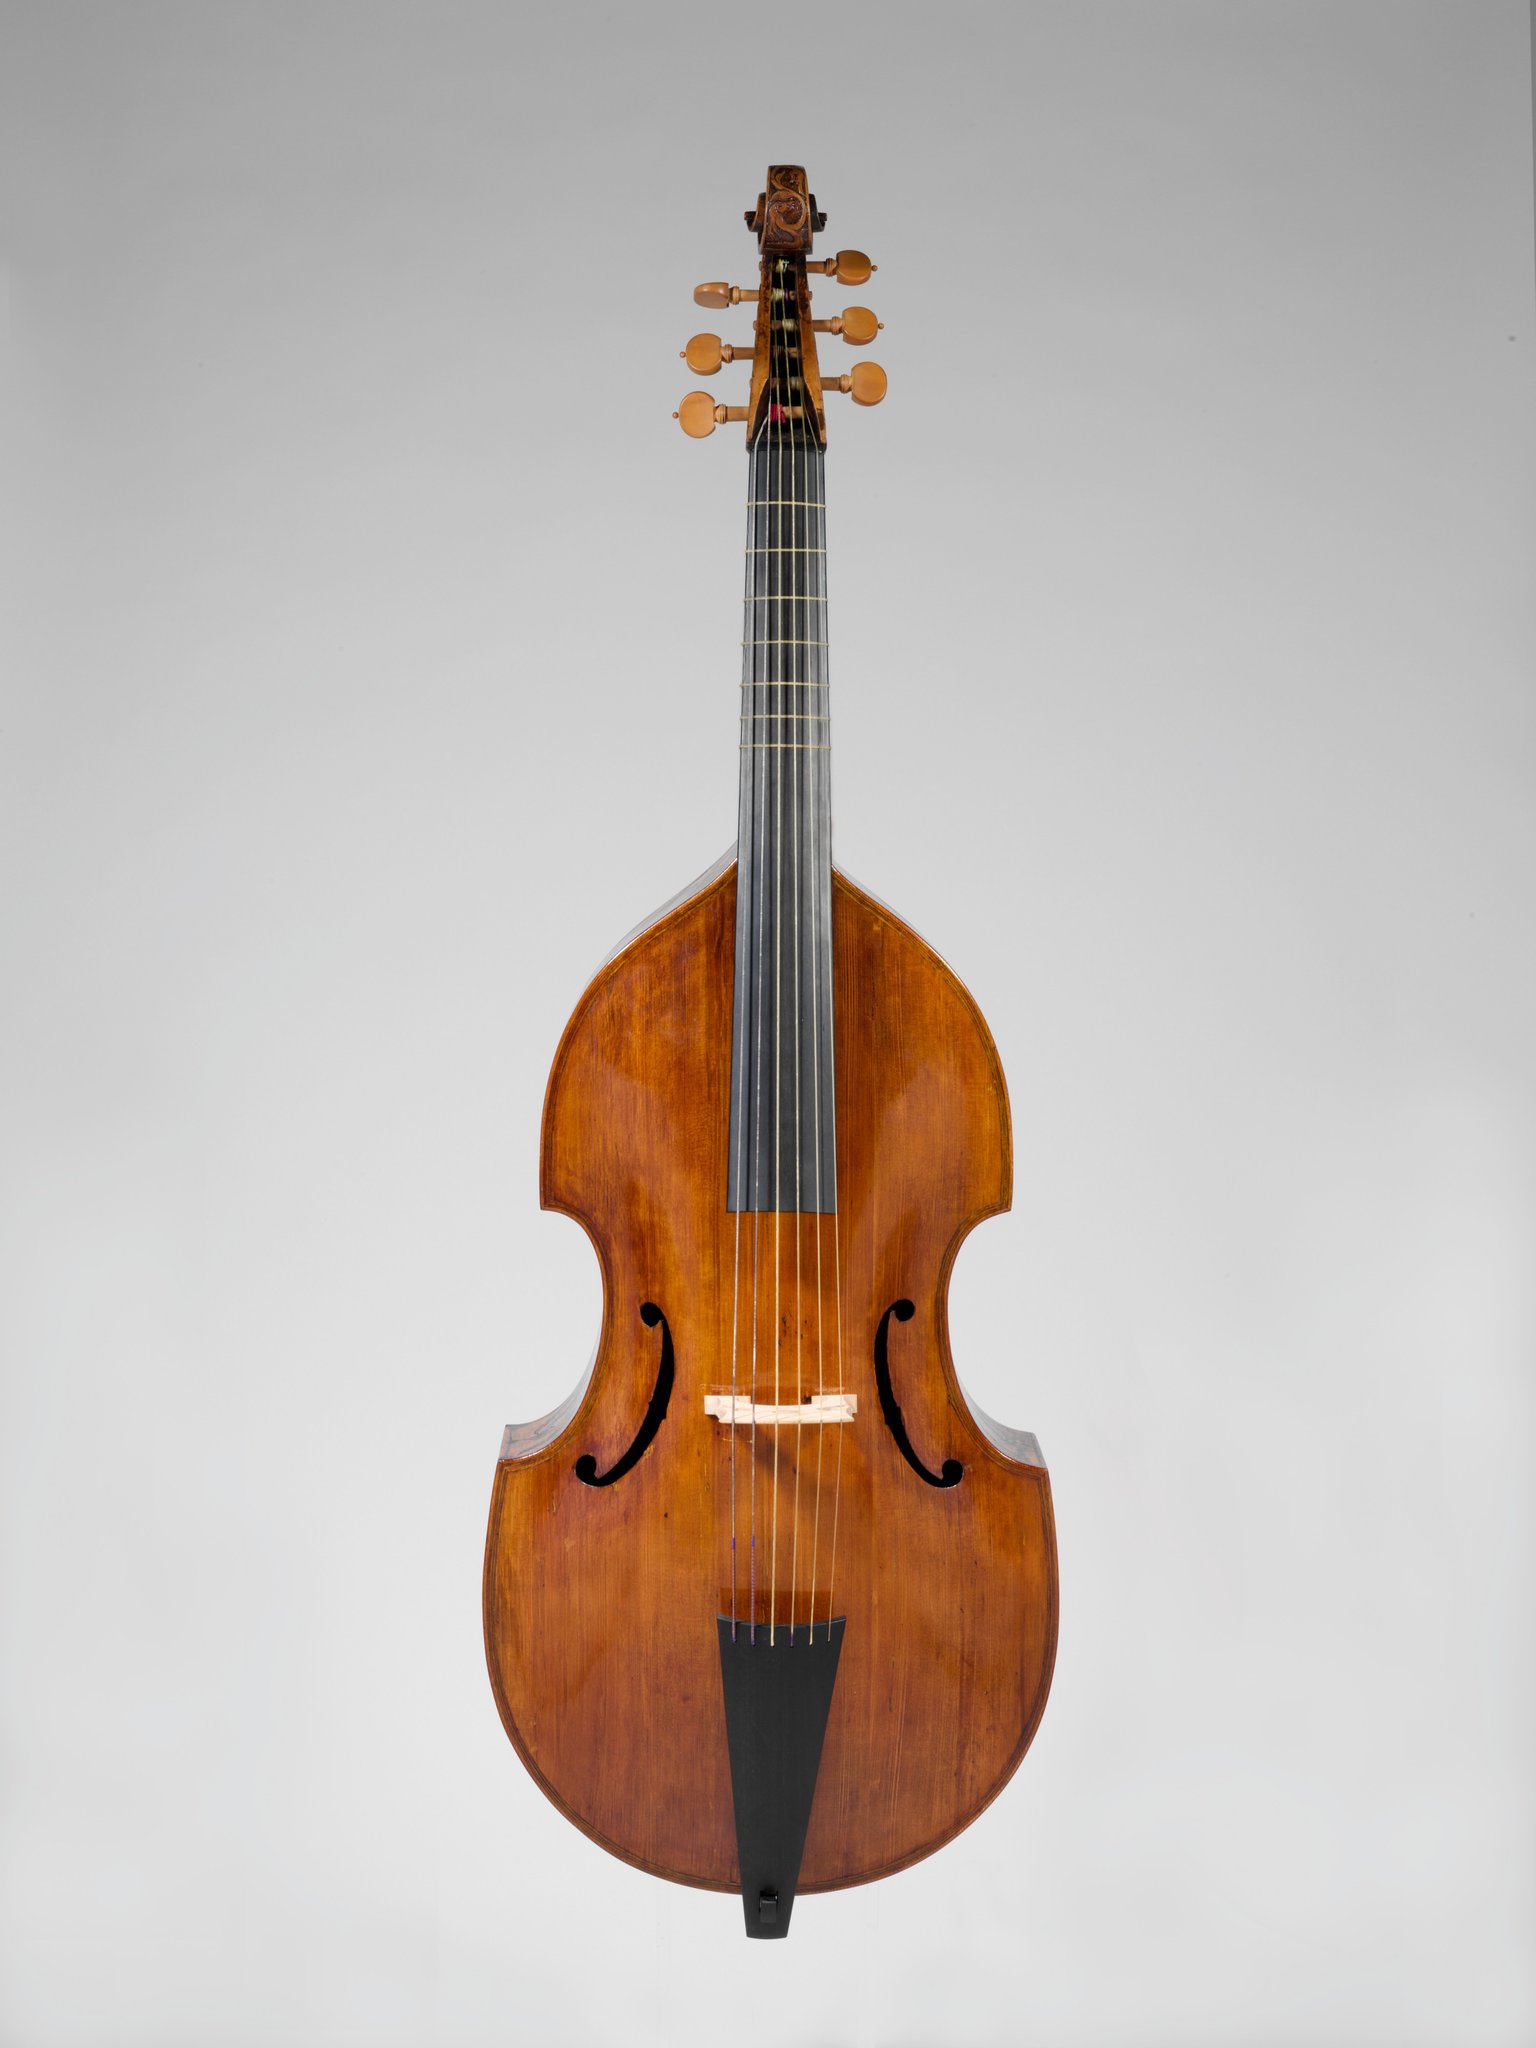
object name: bass viola da gamba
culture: british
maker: john rose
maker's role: maker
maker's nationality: british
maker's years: 1500-1600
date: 1600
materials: wood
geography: united kingdom